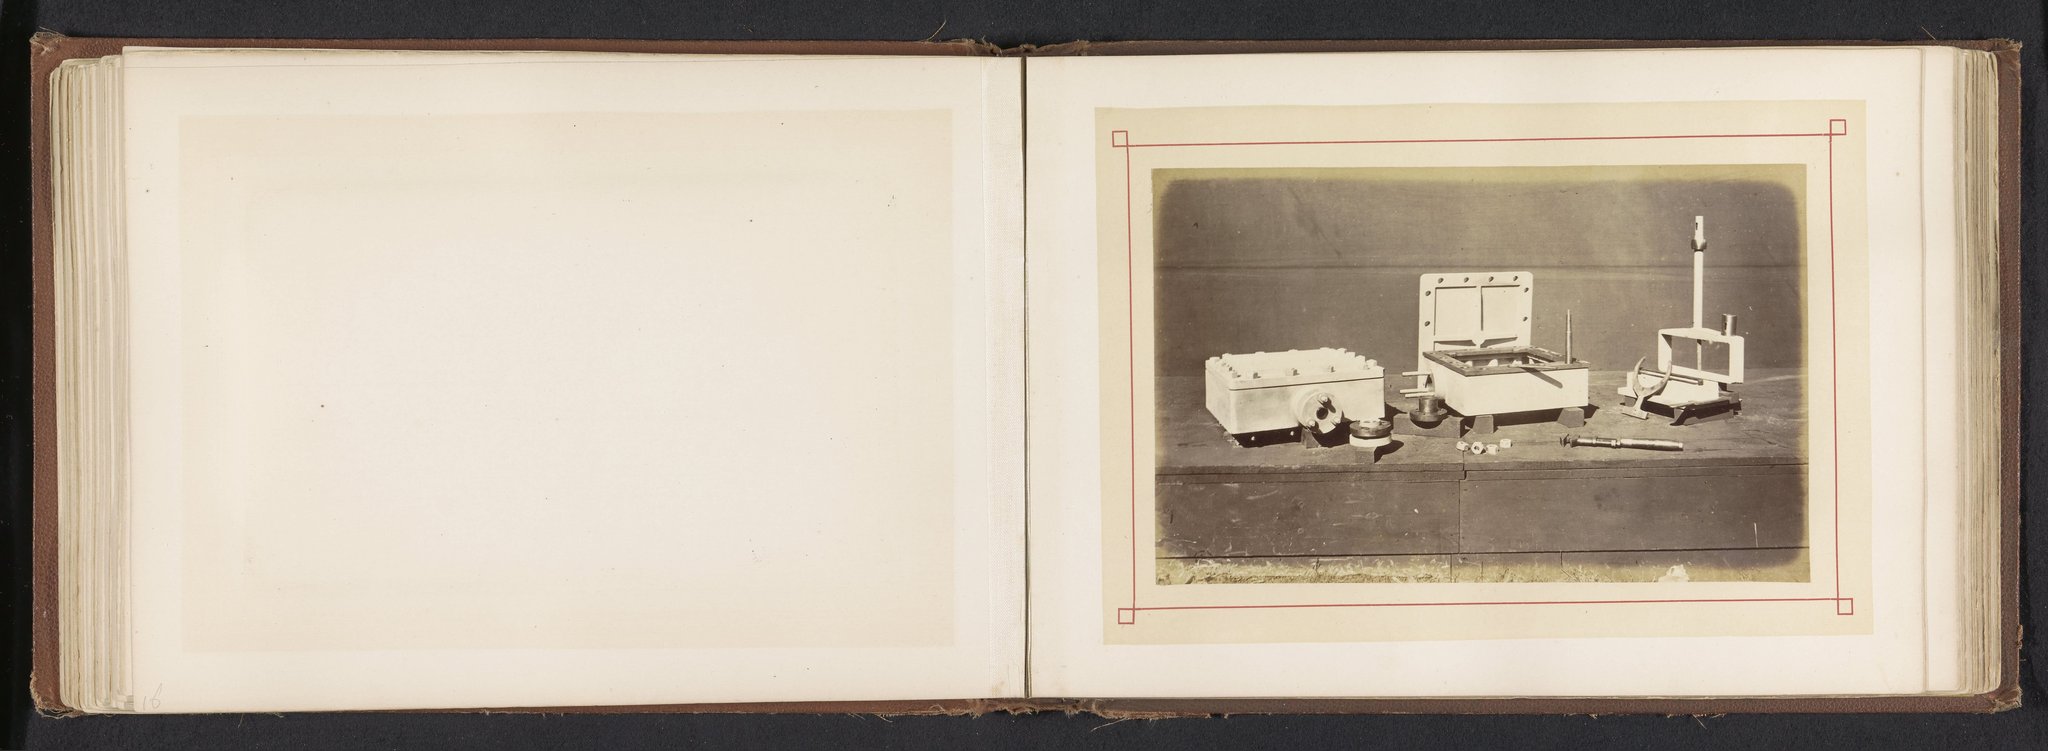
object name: photograph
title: Onderdelen van een stoomlocomotief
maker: george gardner rockwood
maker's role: fotograaf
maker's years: 1832-1911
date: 1861-1871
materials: photographic support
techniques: albumen print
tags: steam locomotive